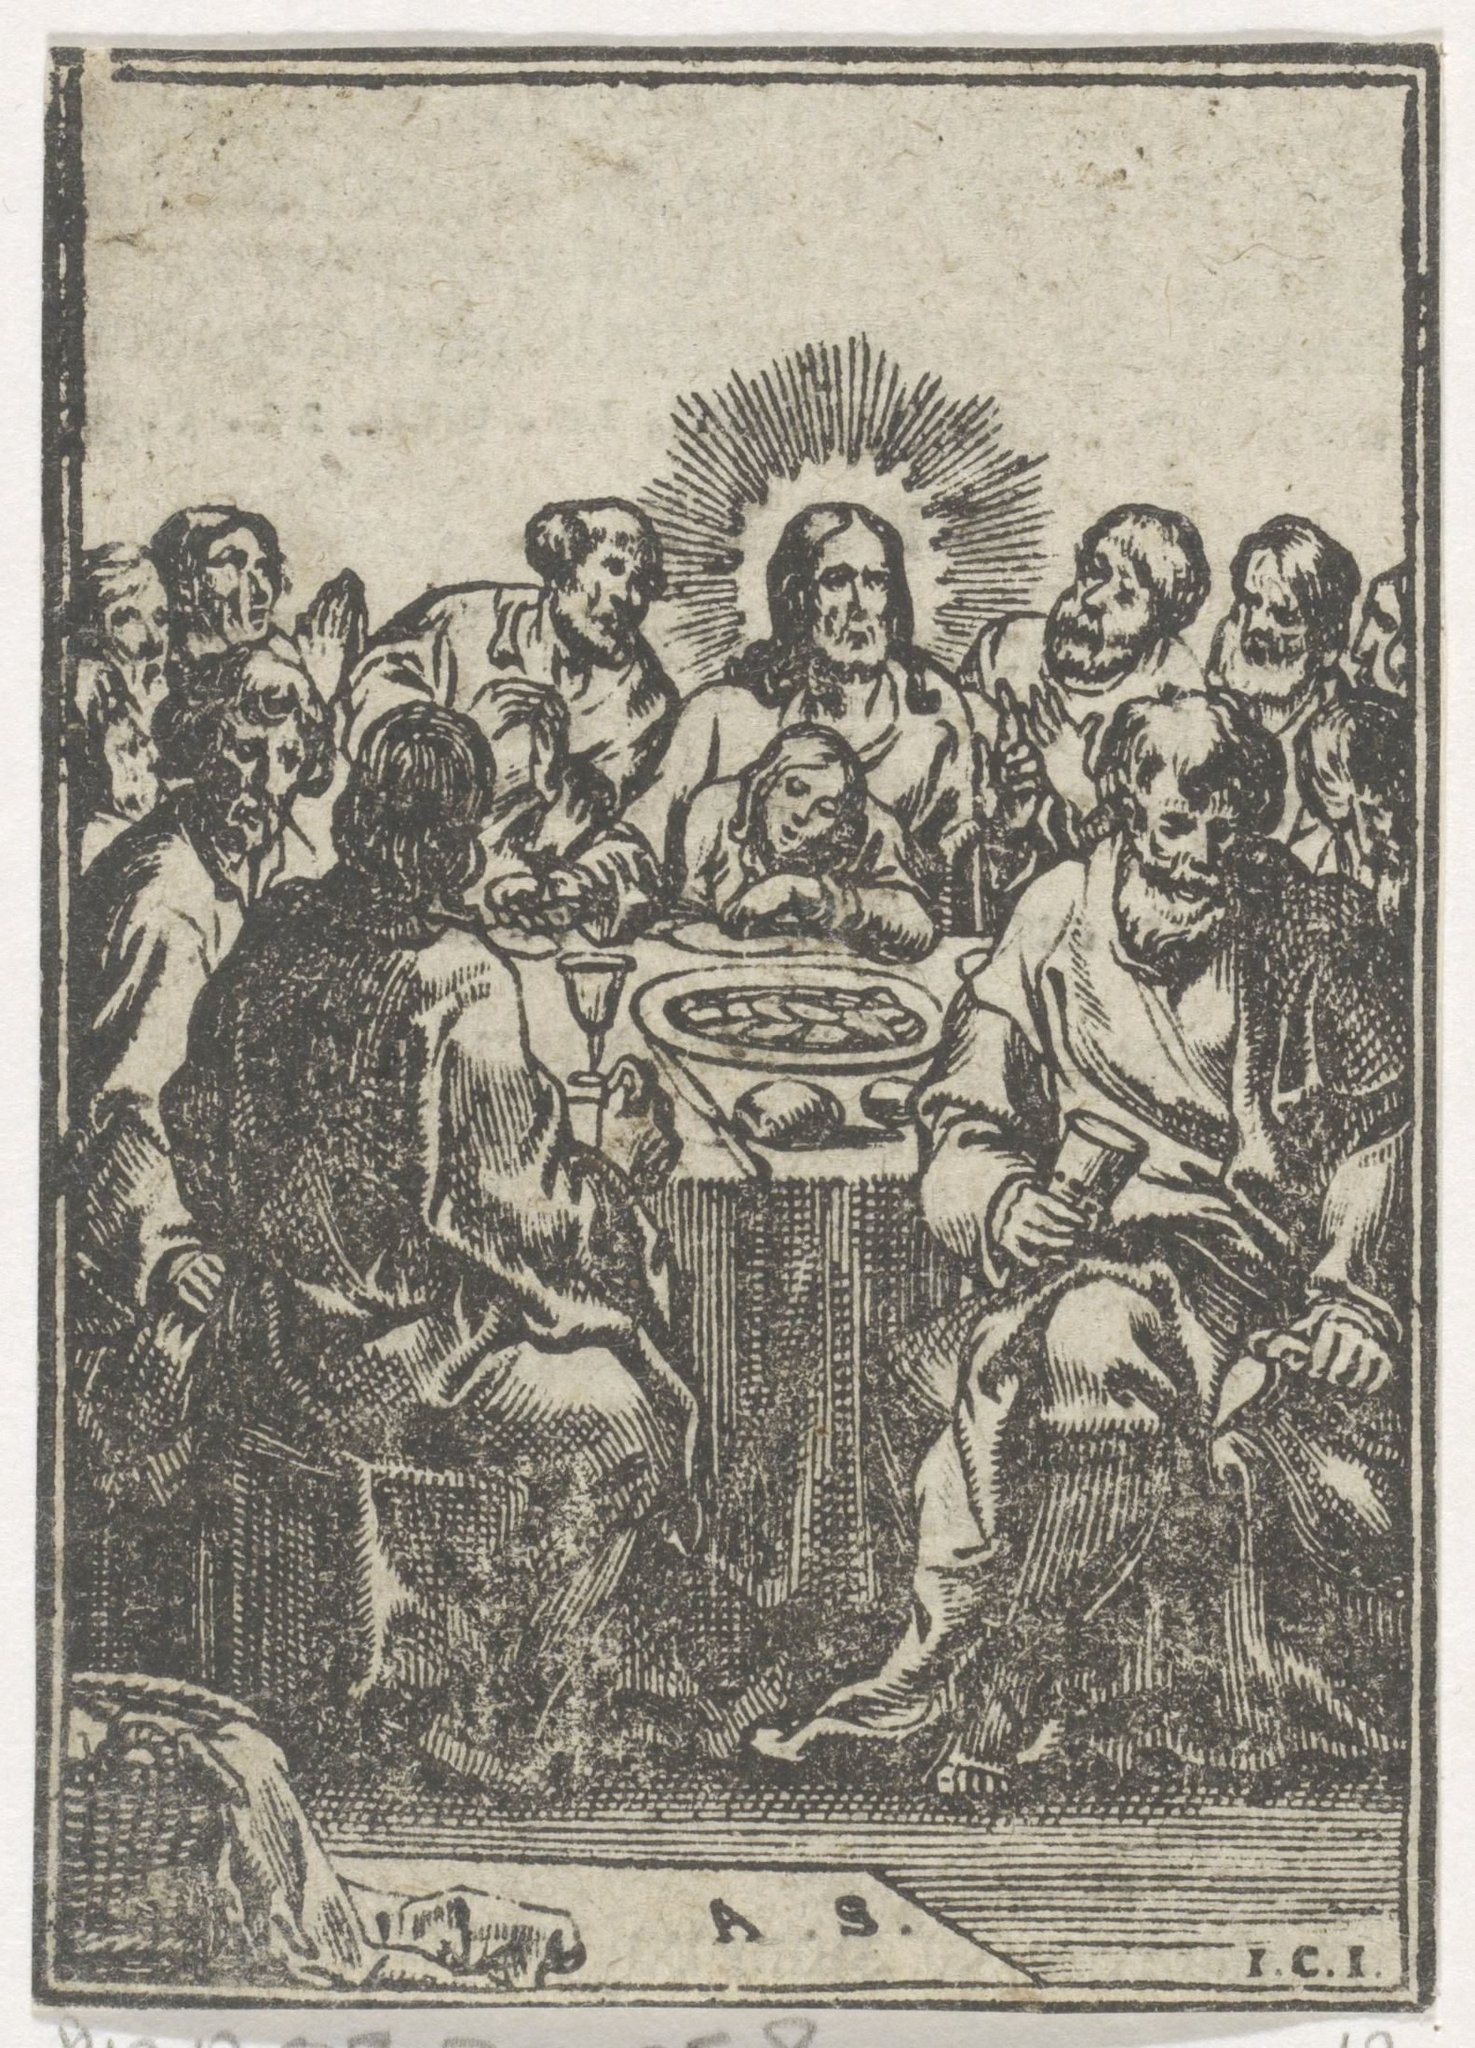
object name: print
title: Laatste avondmaal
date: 1649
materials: paper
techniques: letterpress printing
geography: antwerp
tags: last supper (in general) (matthew 26:21-35; mark 14:18-31; luke 22:3, 22:15-23; john 13:21-38)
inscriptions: collector's mark: Lugt 2228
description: Prent uit: Andries, Judocus. Perpetua crux sive passio Jesu Christi. Antwerpen: Cornelis Woons, 1649.